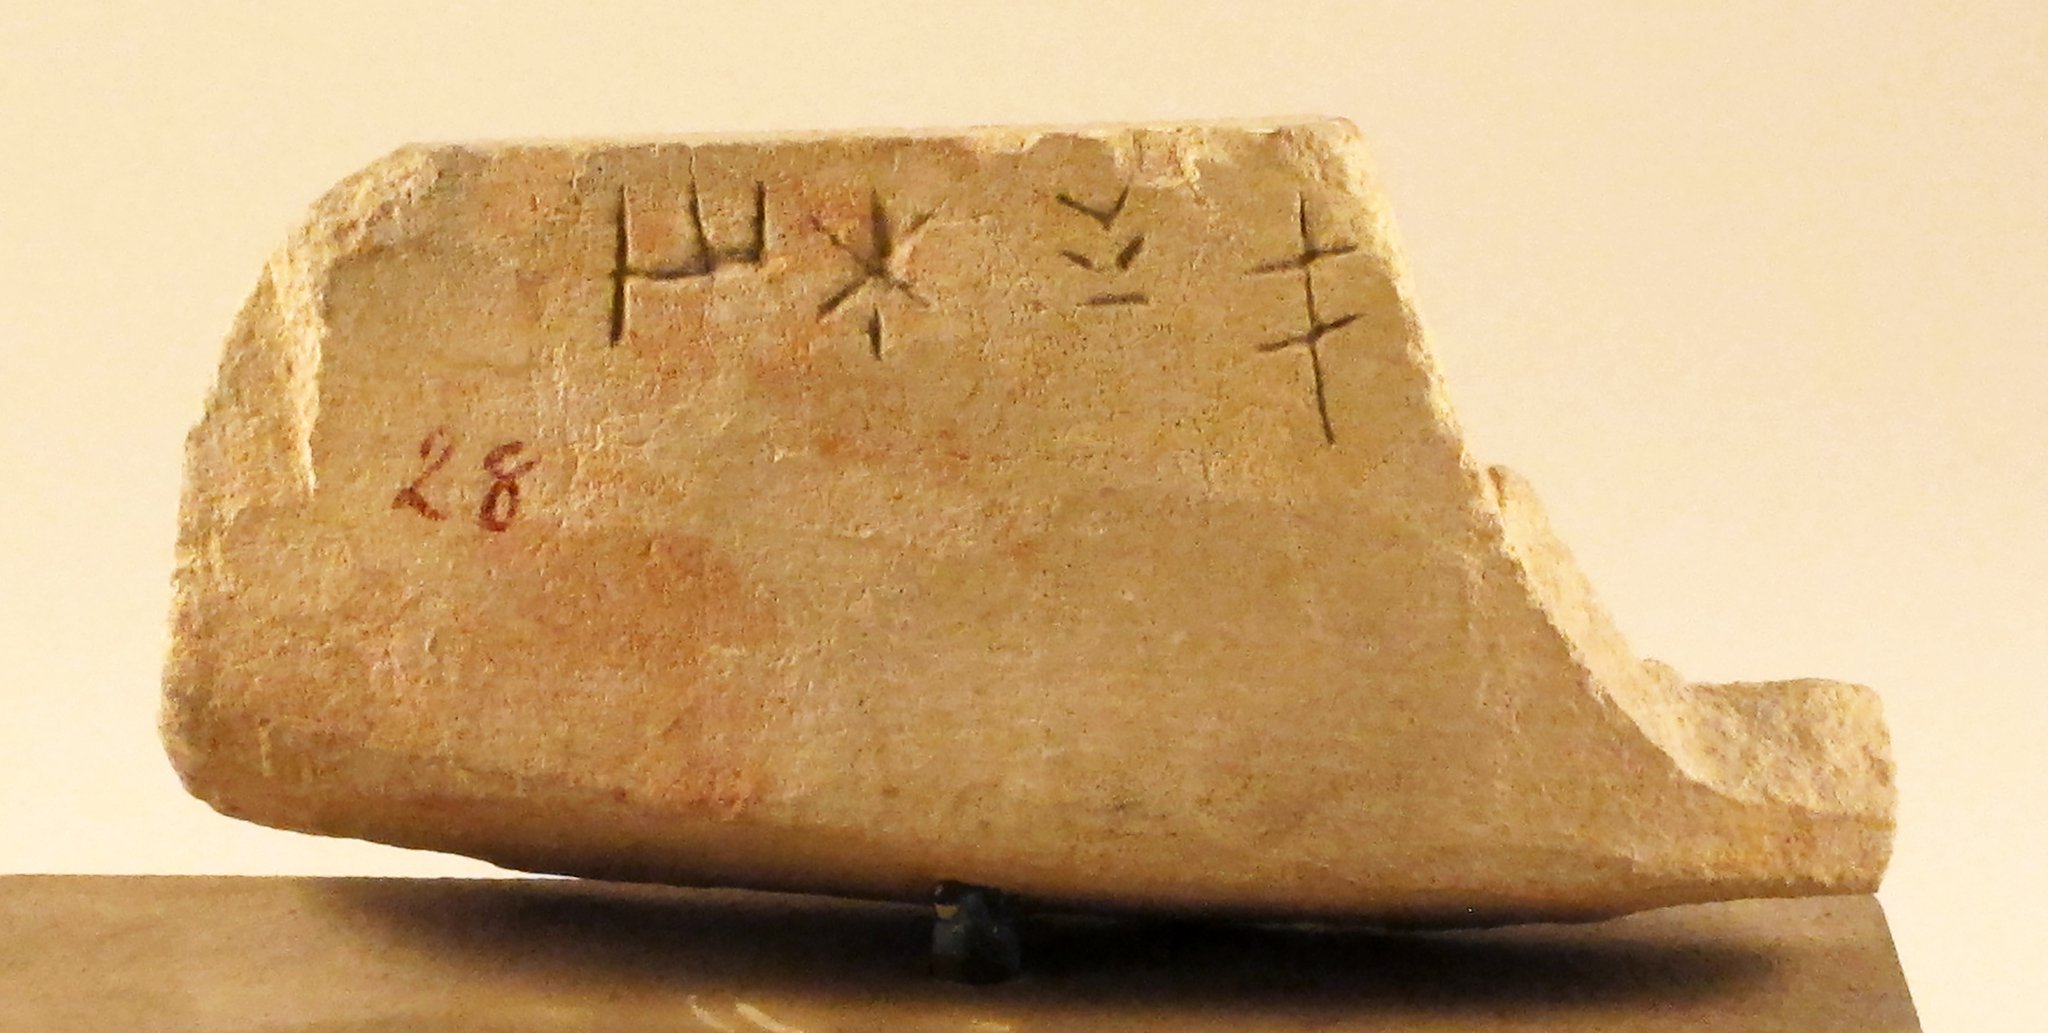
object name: box, inscribed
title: Limestone inscribed box fragment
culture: cypriot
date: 3900 BCE-100 CE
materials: stone